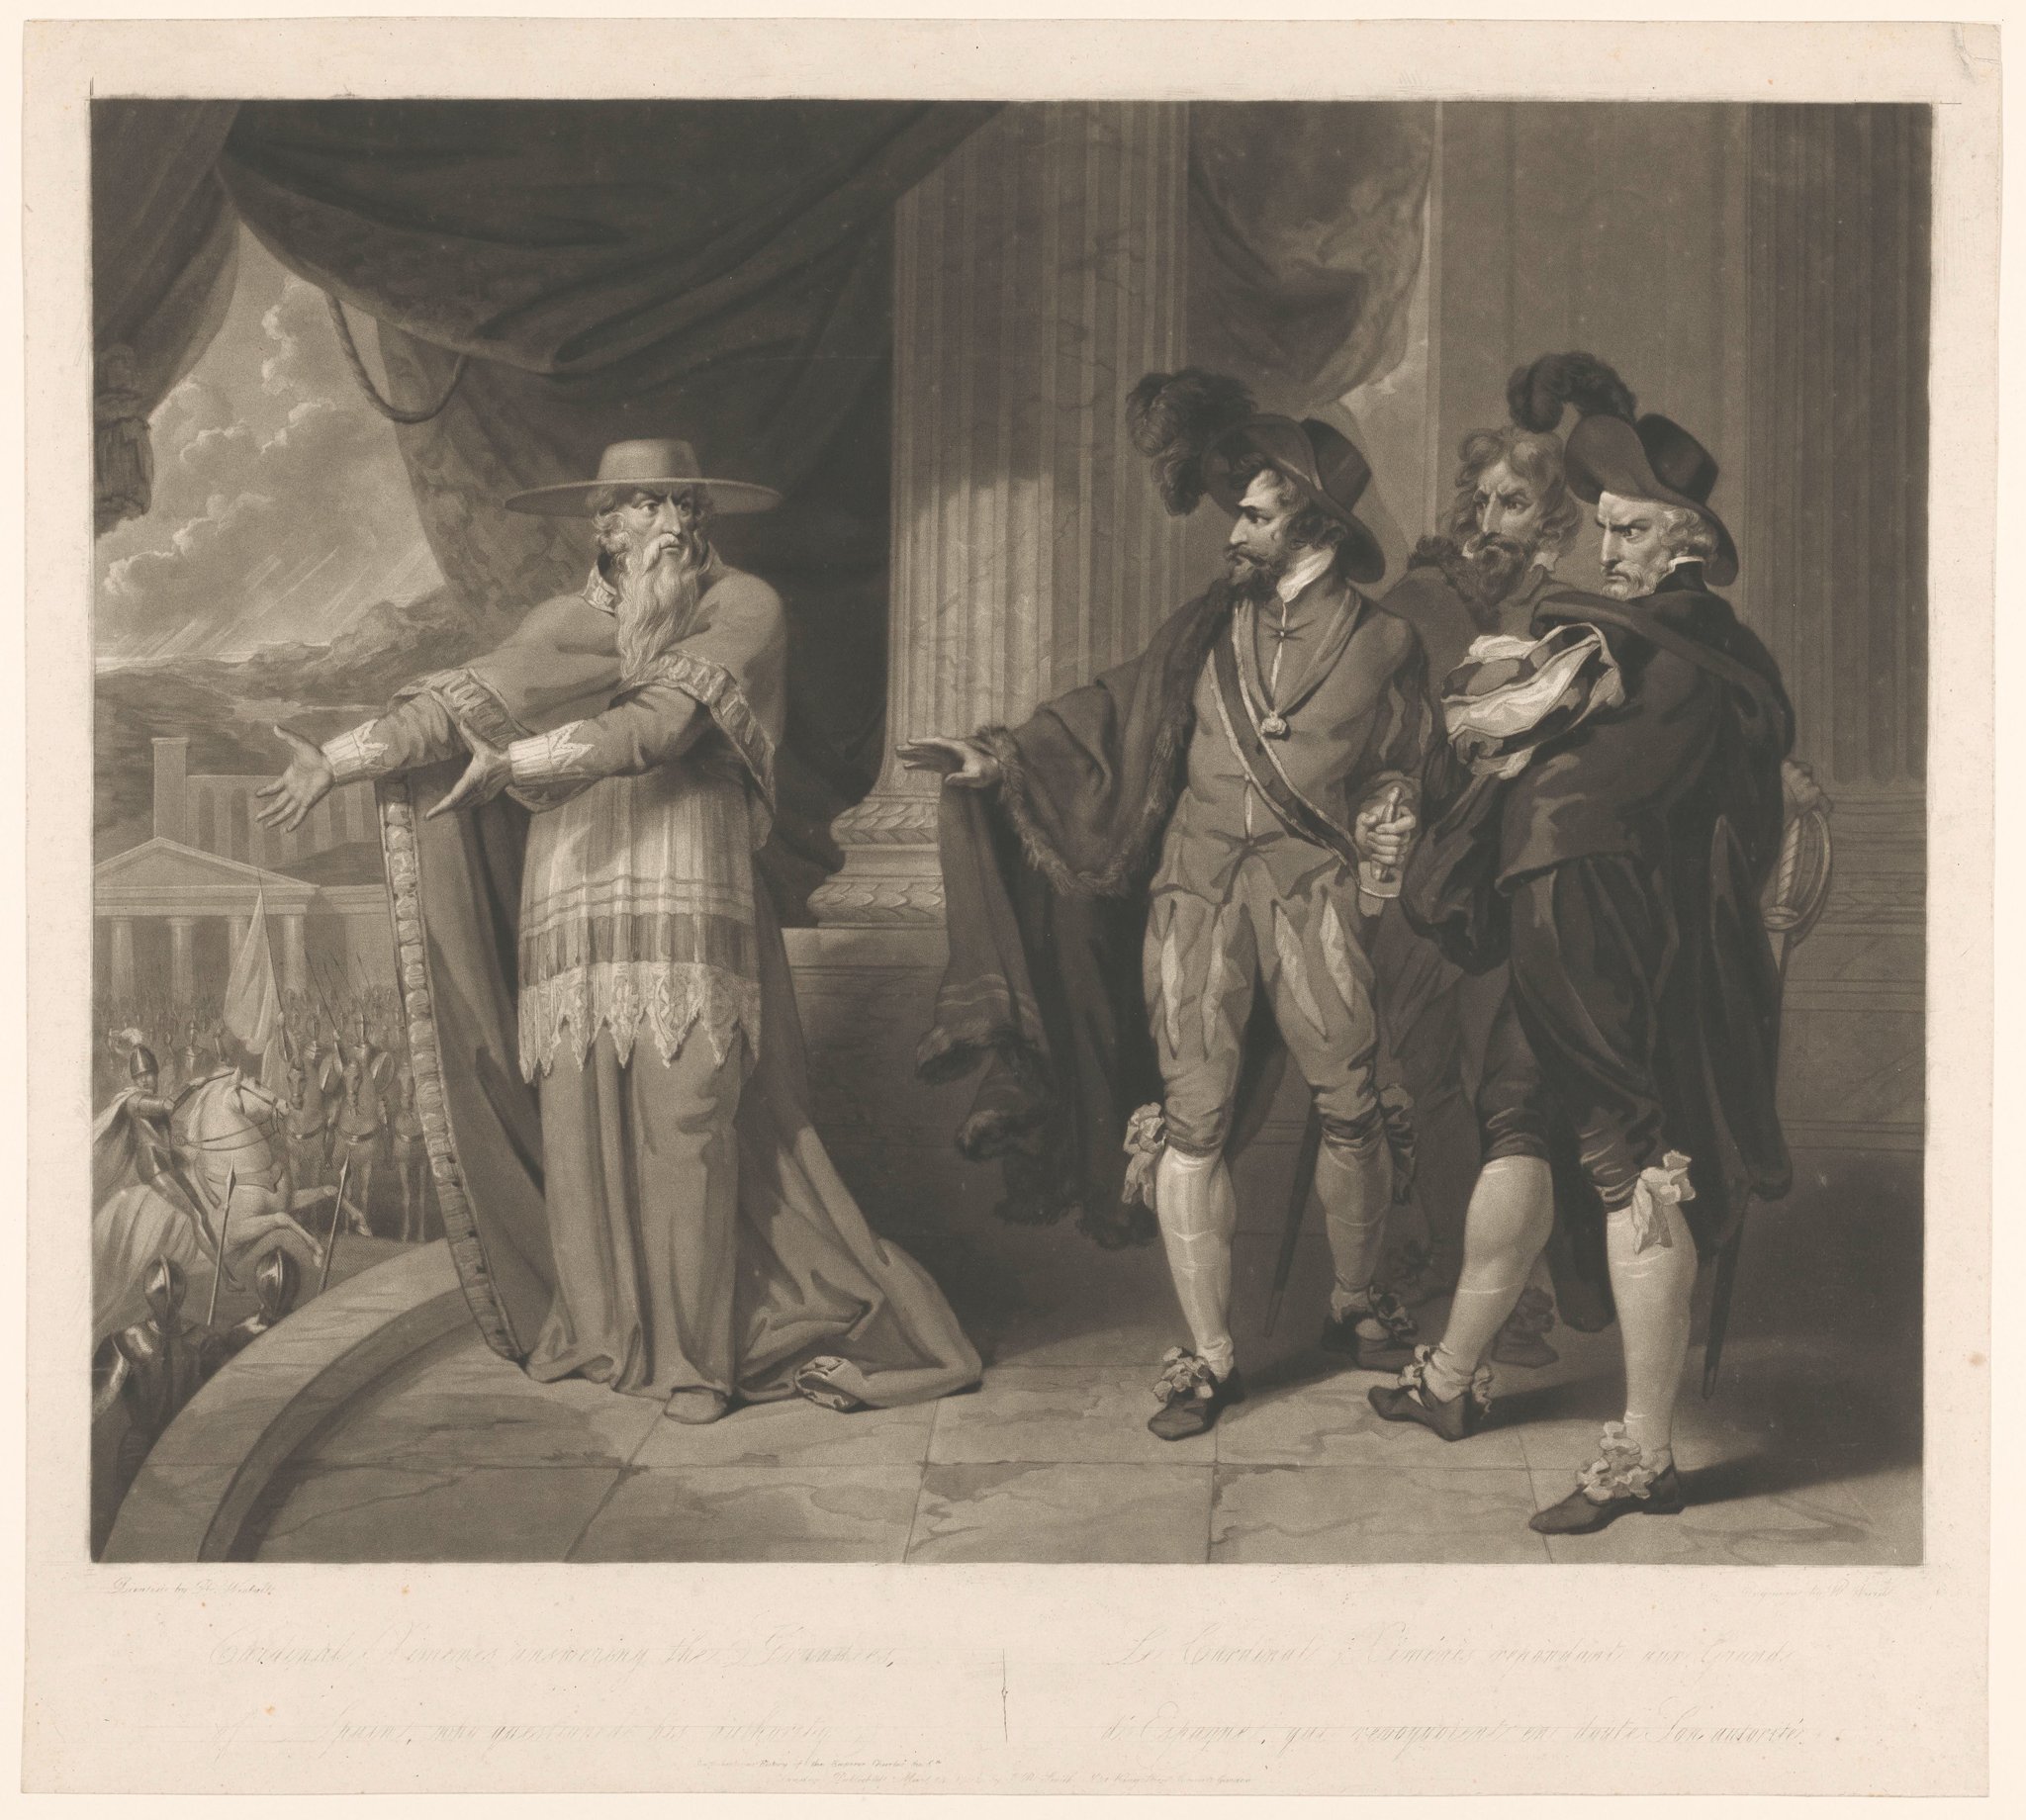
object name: print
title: Cardinal Ximenes answering the Grandees of Spain who questioned his authority / Le Cardinal Ximénes repondant aux Grands d'Espagne, qui revoyuoient son autorité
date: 1792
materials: paper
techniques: mezzotint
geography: england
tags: cardinal, royal household; courtiers, retinue, train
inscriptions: collector's mark: Lugt 2228, inscription: ‘No 134’